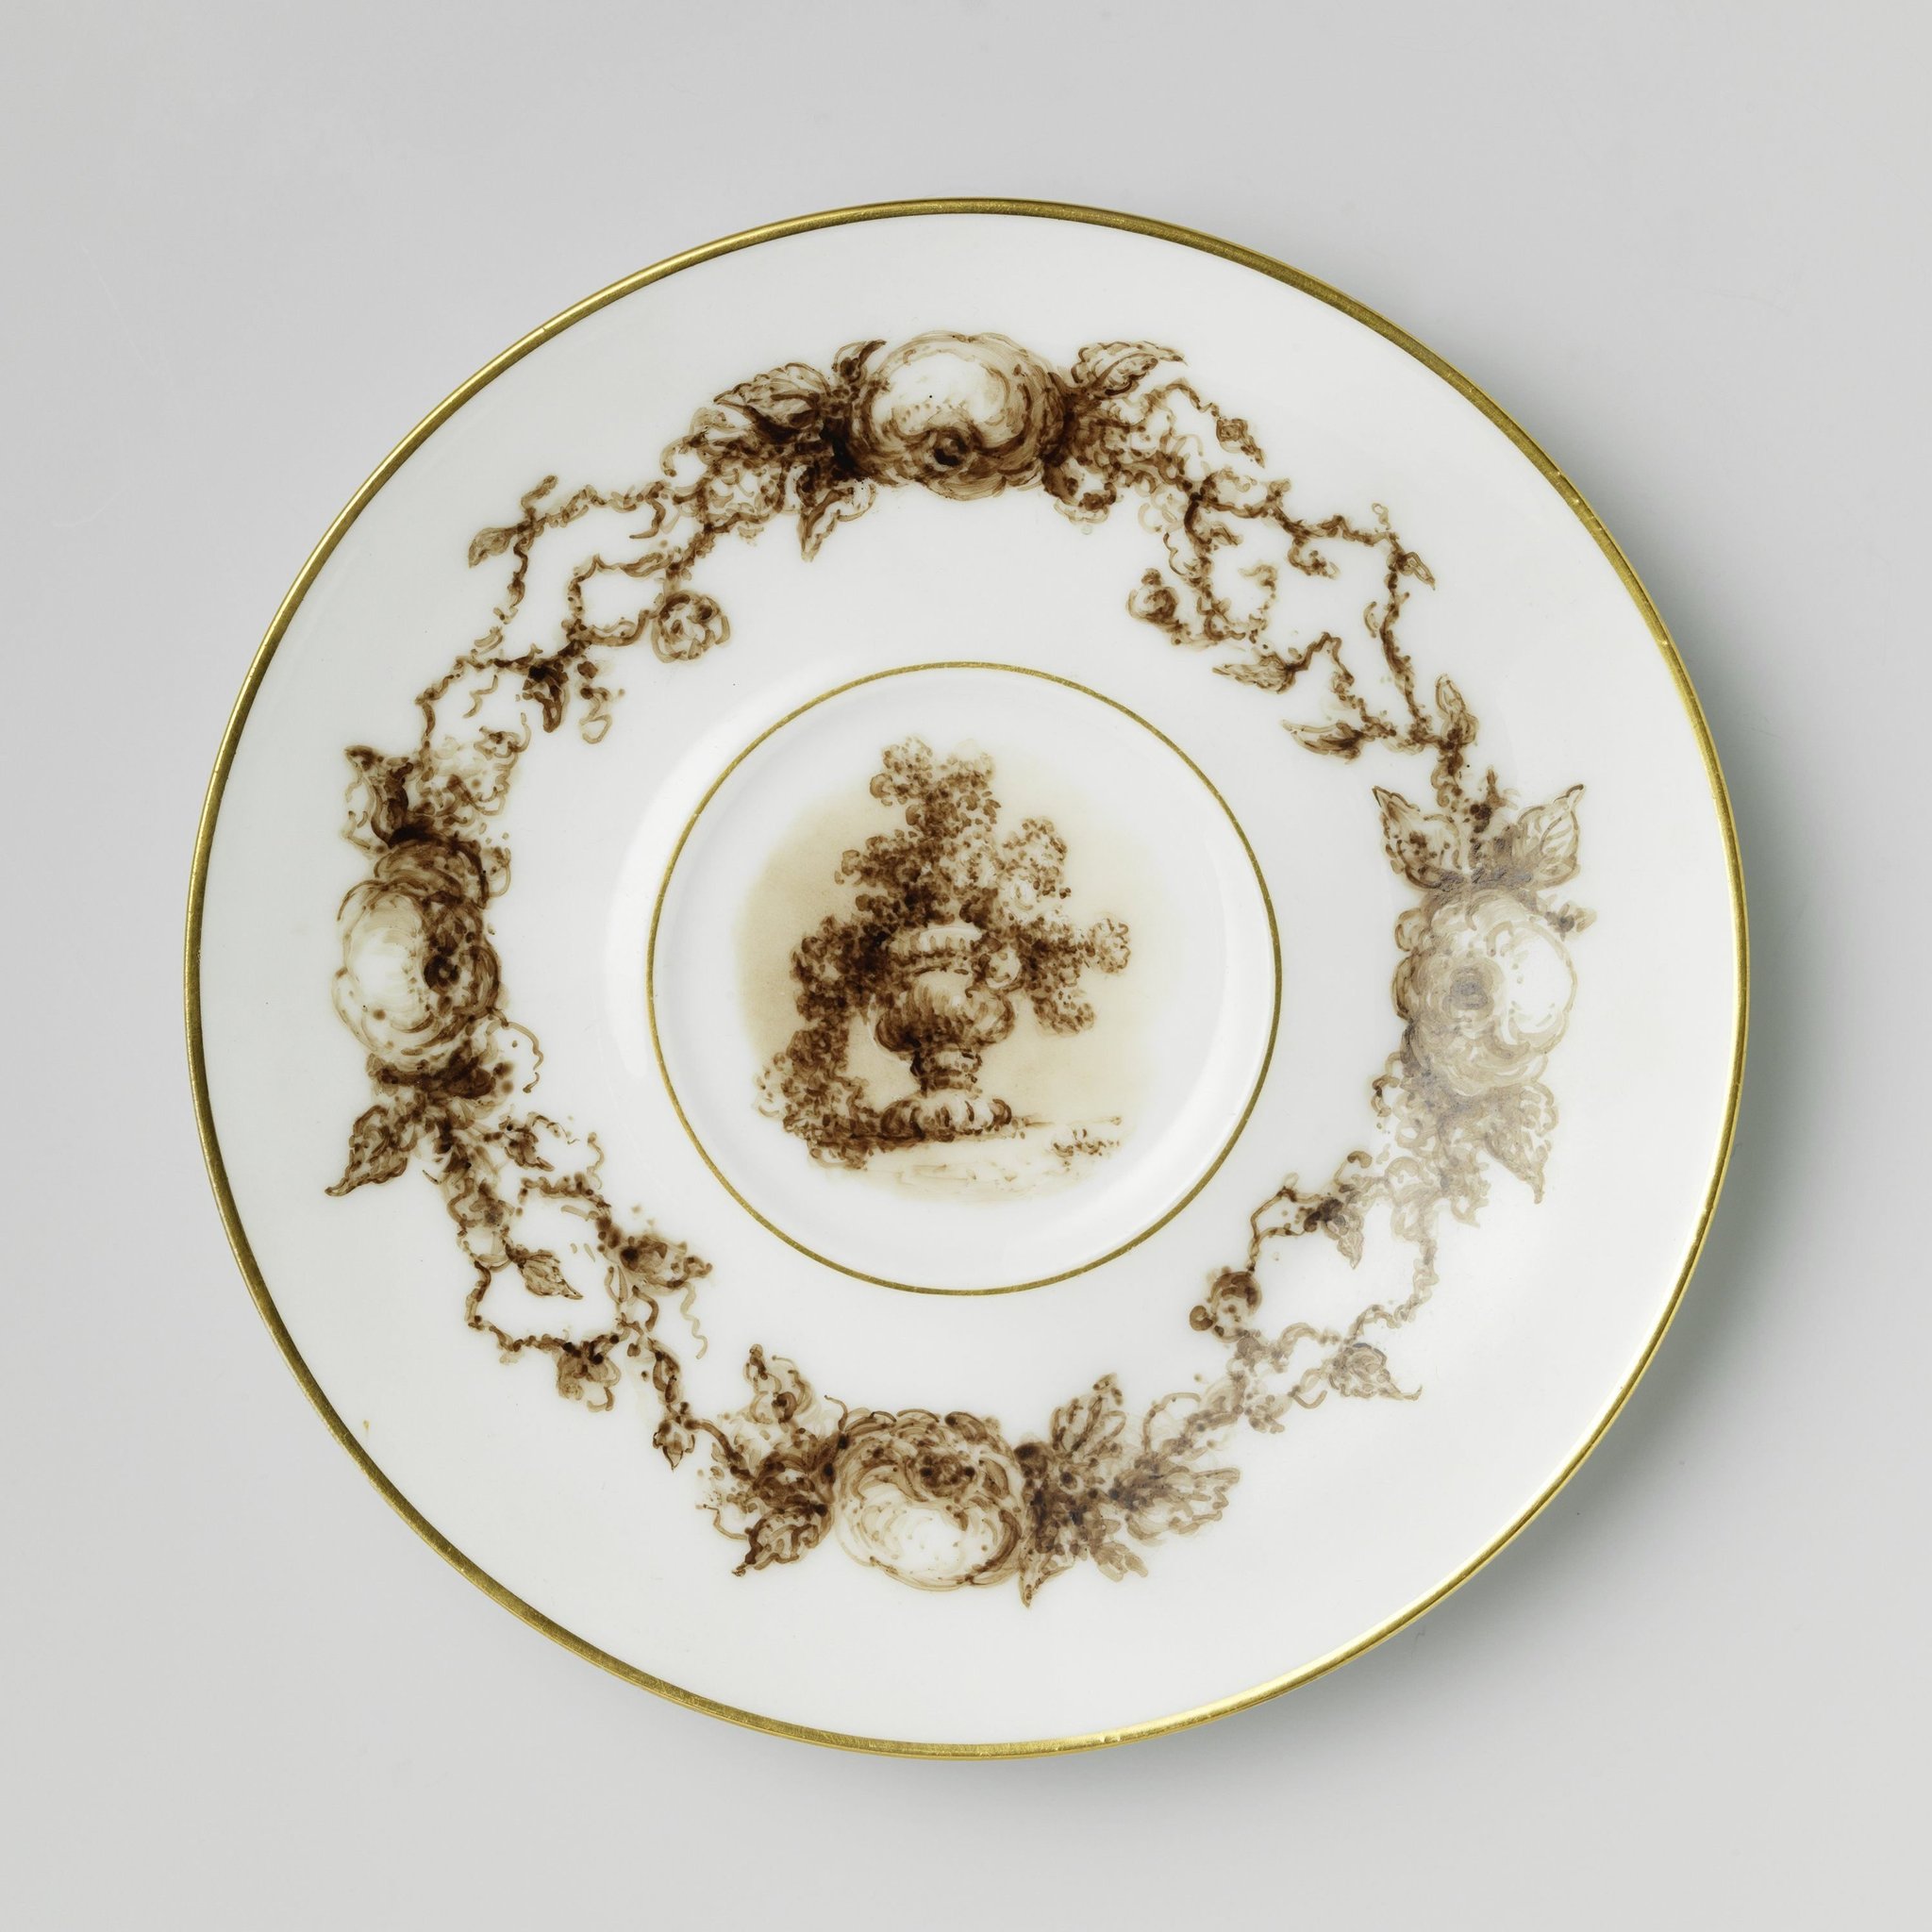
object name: cup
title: Kop beschilderd in sepia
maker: eduard alexander hilverdink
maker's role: draughtsman, painter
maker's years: 1846-1891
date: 1879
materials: porcelain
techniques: painted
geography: netherlands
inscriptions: date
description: Kop beschilderd in sepia met een vaas met bloemen omgeven door een krans van bloemen. De kop met een gezicht op de Boerenwetering met het Rijksmuseum in aanbouw. Op de kop is de voorstelling gesigneerd E.Alex.H.